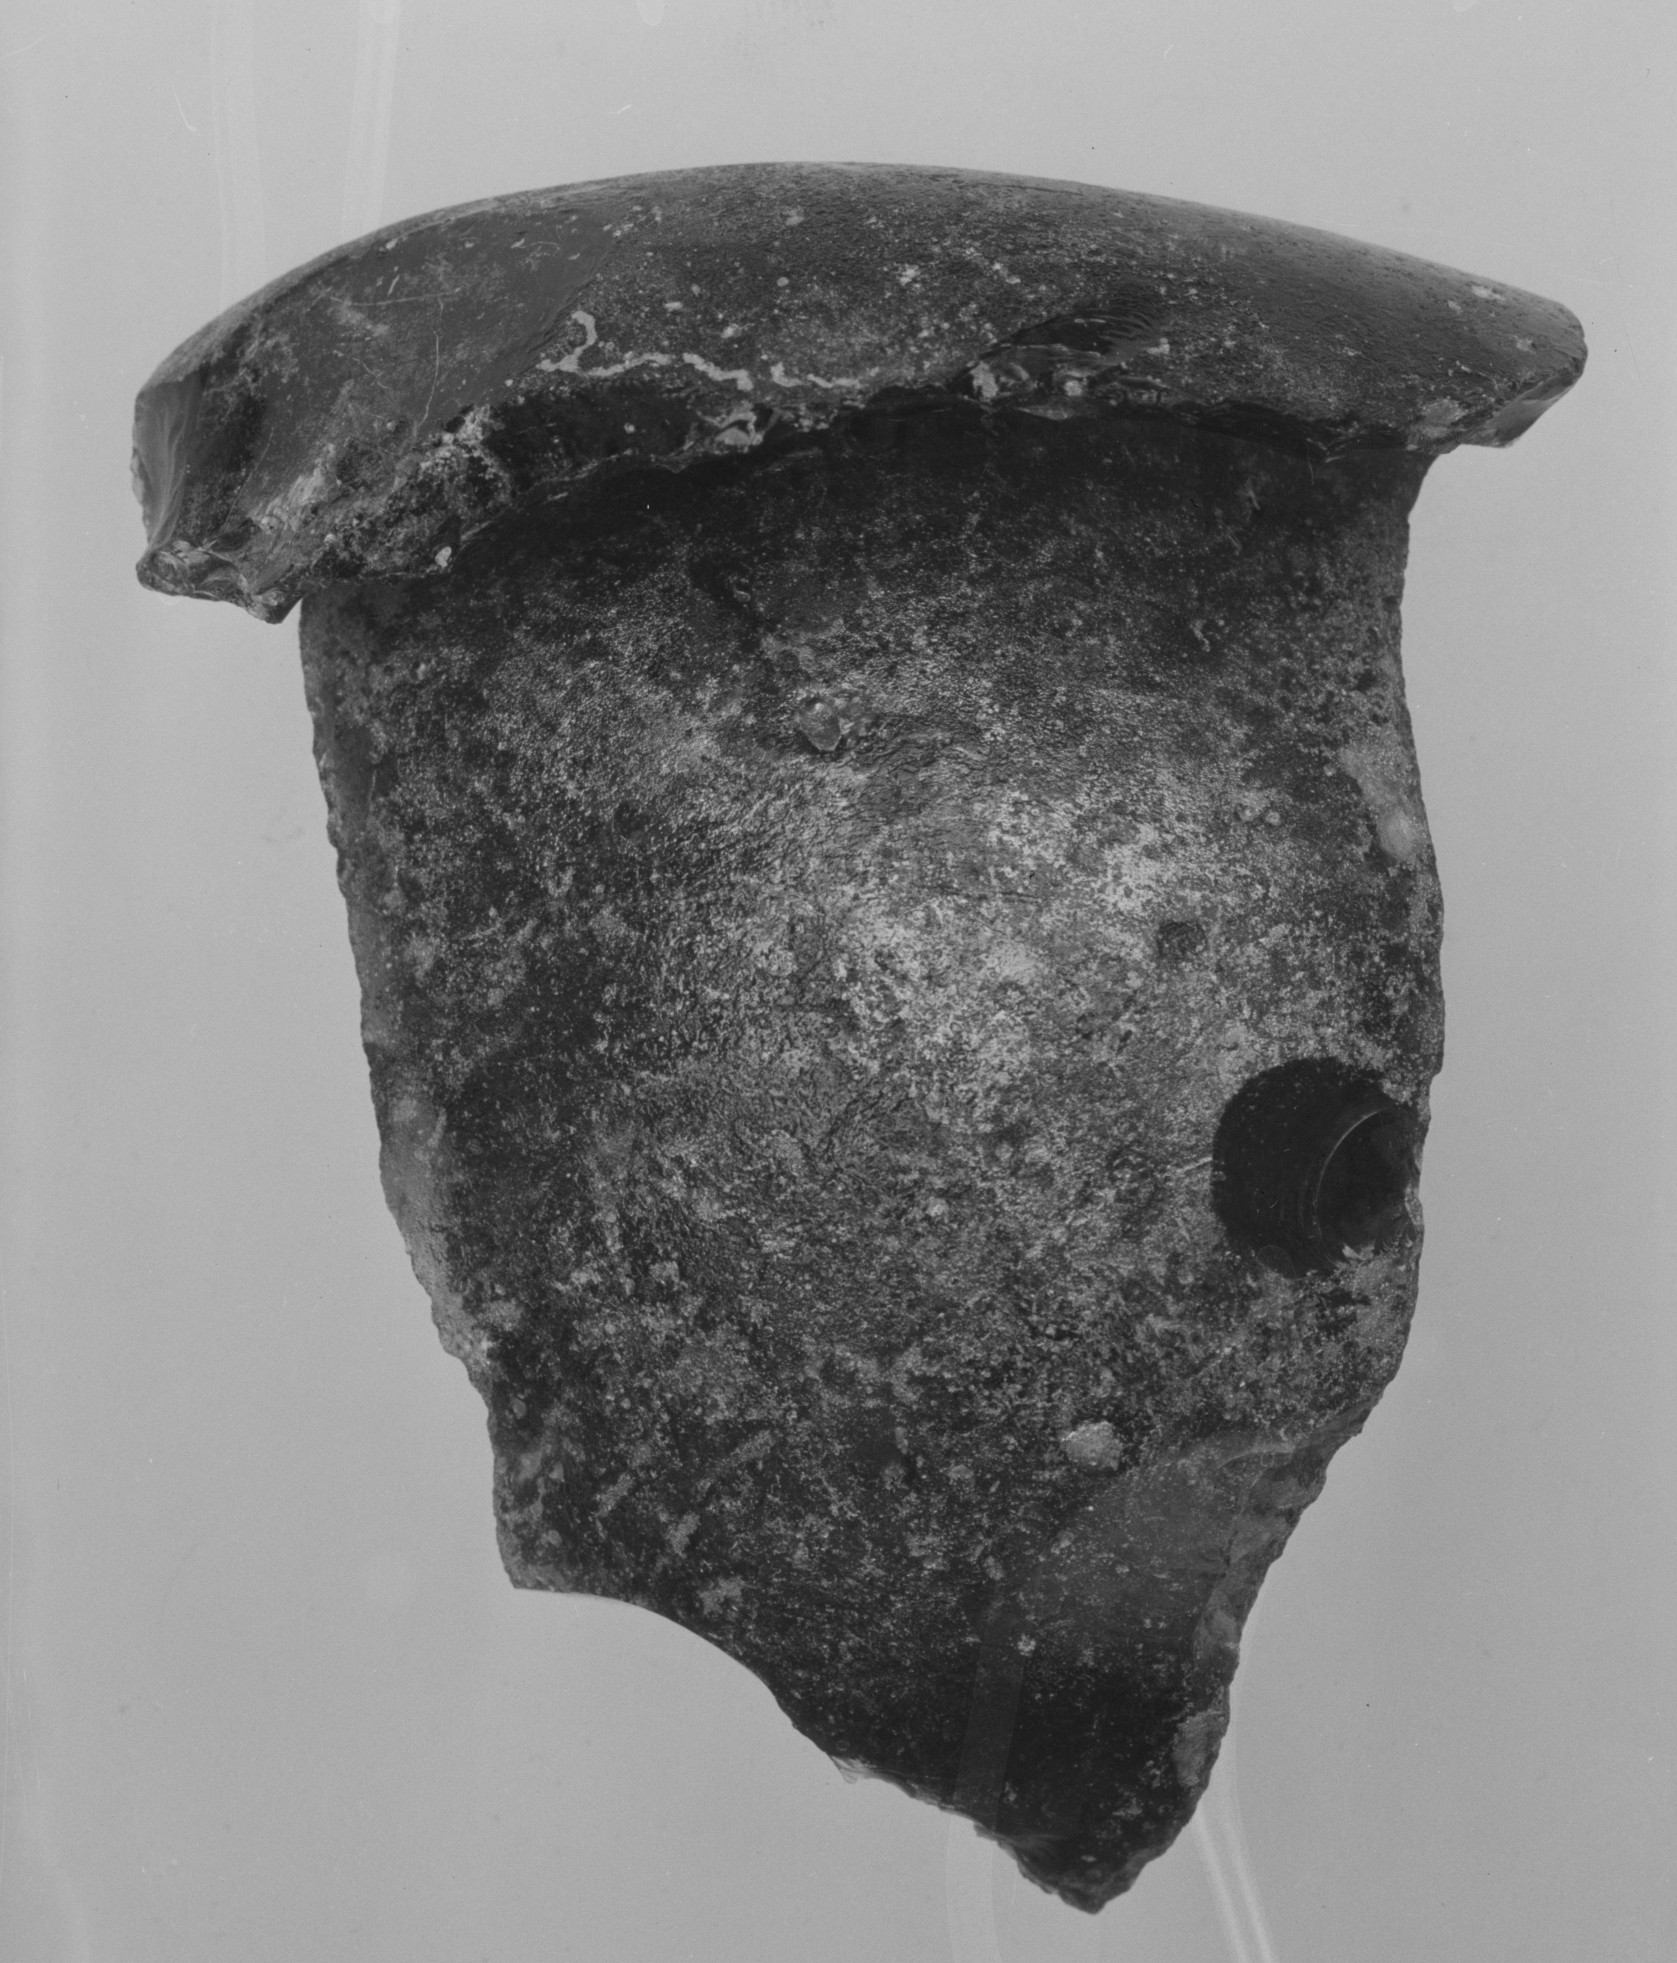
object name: bottle fragment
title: Fragment of a Bottle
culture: american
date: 1701-1800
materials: glass, lead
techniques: glassblowing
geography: united states